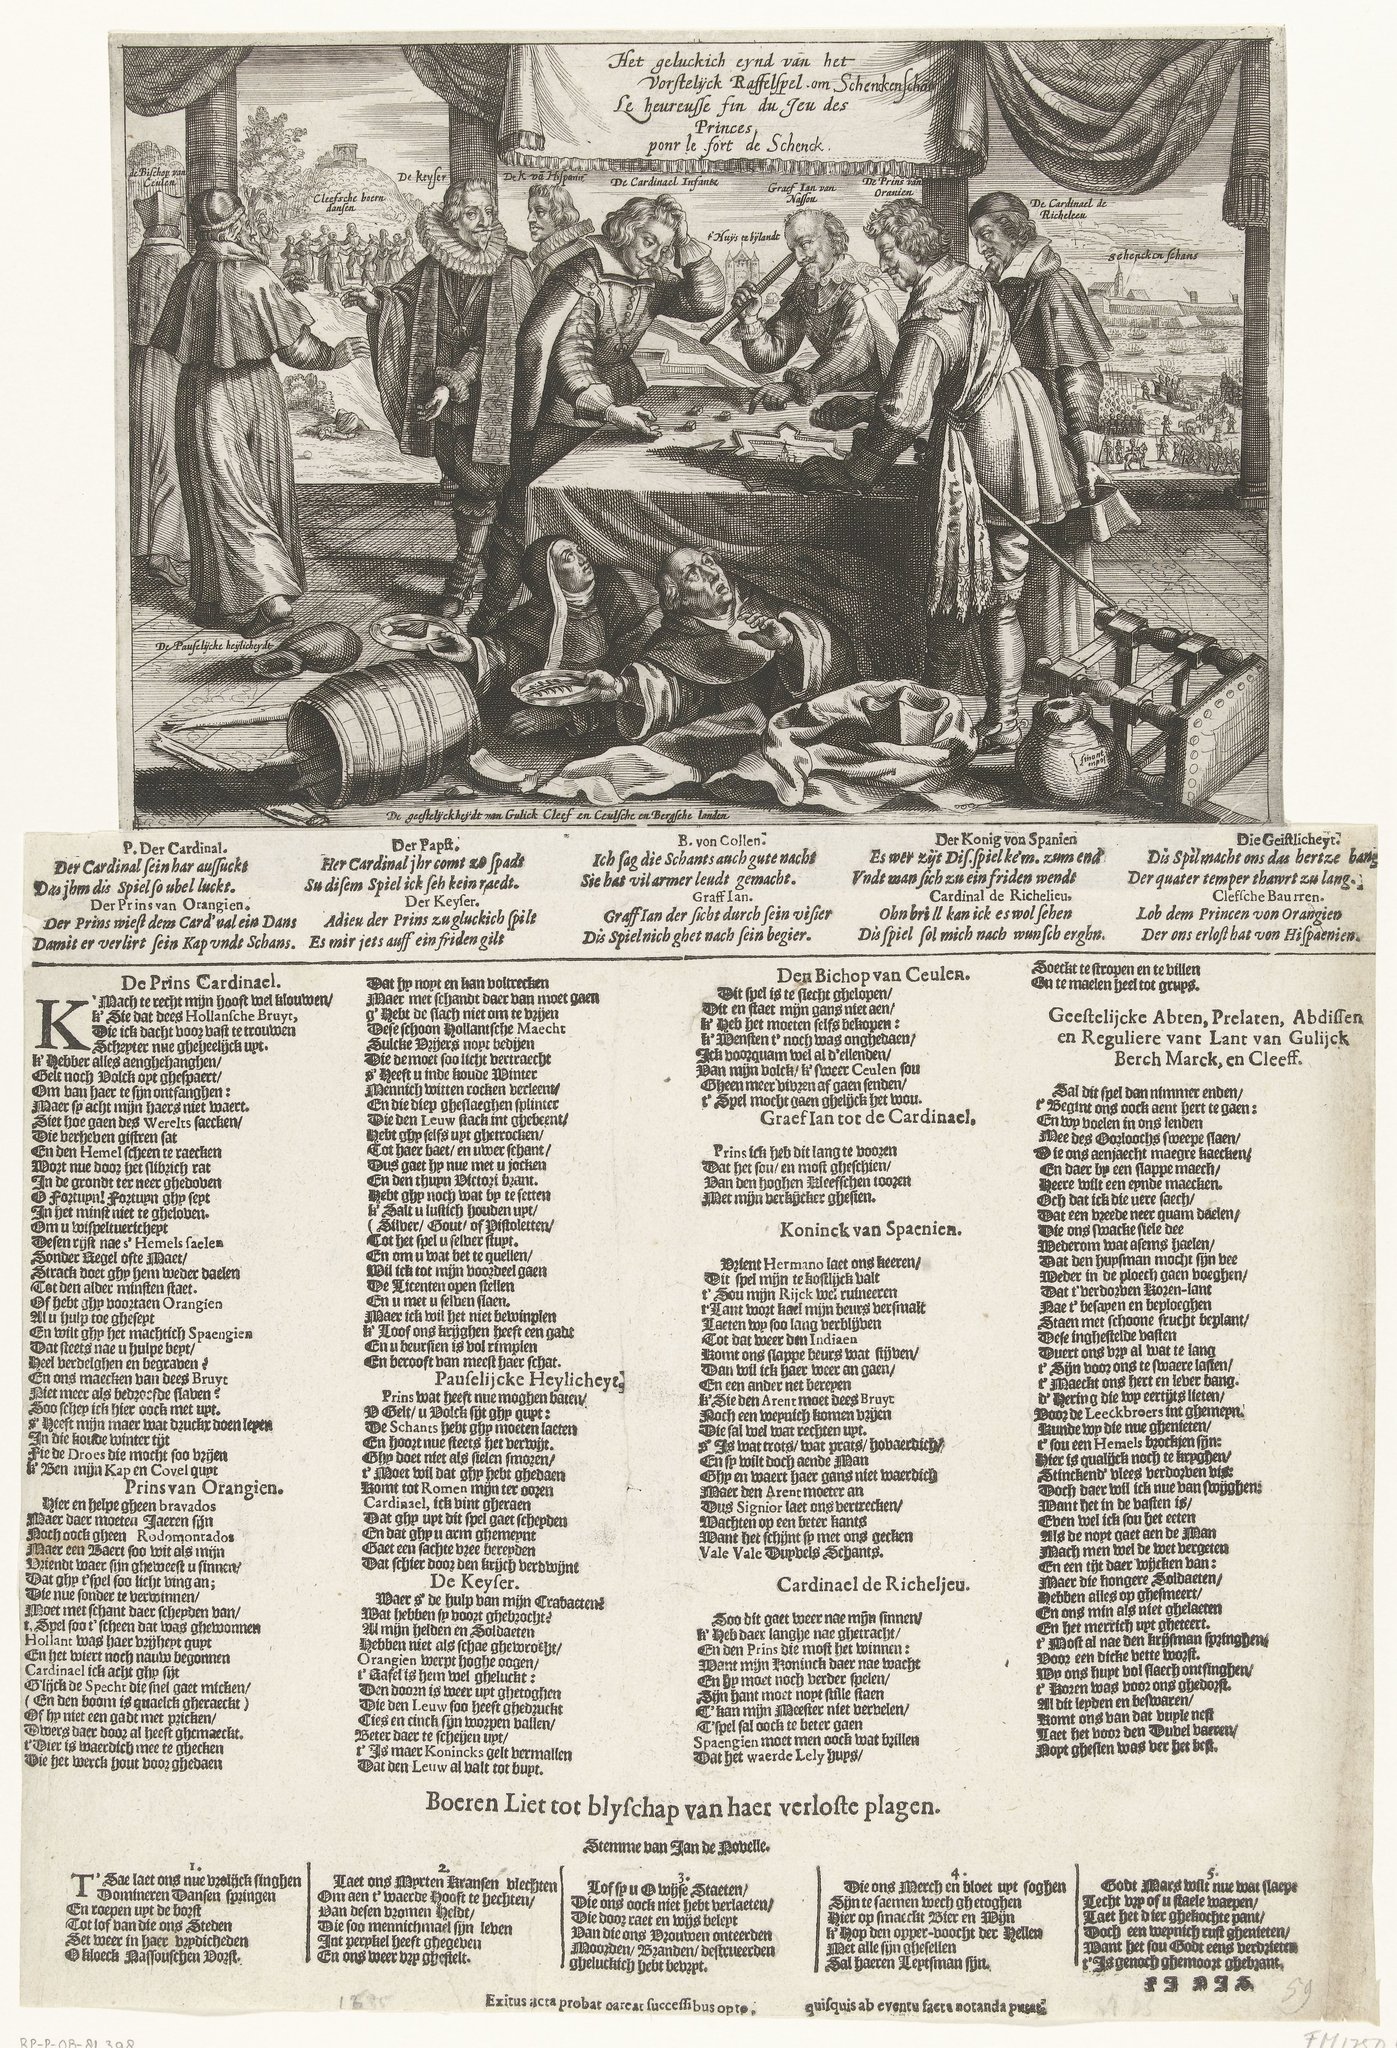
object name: print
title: Einde van het spel om Schenckenschans, 1635-1636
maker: Anonymous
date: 1636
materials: paper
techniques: engraving, etching, letterpress printing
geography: northern netherlands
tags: delft, the hague, frederick henry (prince of orange), filips iv (koning van spanje), vienna, ferdinand ii (duits keizer), clergyman, urbanus viii, ferdinand van beieren, paris, armand-jean du plessis hertog van richelieu, brussels, landvoogd der zuidelijke nederlanden ferdinand van oostenrijk, capture of city (after the siege), dice-games, political caricatures and satires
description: Spotprent op de strijd om Schenckenschans in de jaren 1635-1636. Het einde van het spel om de schans. Frederik Hendrik en de kardinaal infant Ferdinand dobbelen aan een tafel om het fort. De stadhouder gooit de winnende worp. De kardinaal infant krabt zich op het hoofd, graaf Johan van Nassau kijkt naar de stenen door een verrekijker. Links vertrekken de paus, de bisschop Keulen, de koning van Spanje en de keizer. Rechts kijkt kardinaal Richelieu toe. Links op de achtergrond dansen de Kleefse boeren van blijdschap. Van onder de tafel komen een priester en een non tevoorschijn. Rechts op de achtergrond de verovering van het fort door het Staatse leger op 29 april 1636. Onder de prent is vastgeplakt een groter blad met 4 kolommen tekst in het Nederlands. Aan de bovenkant 10 verzen van de hoofdrolspelers in het Duits. Aan de onderkant een Nederlands lied in 4 verzen.